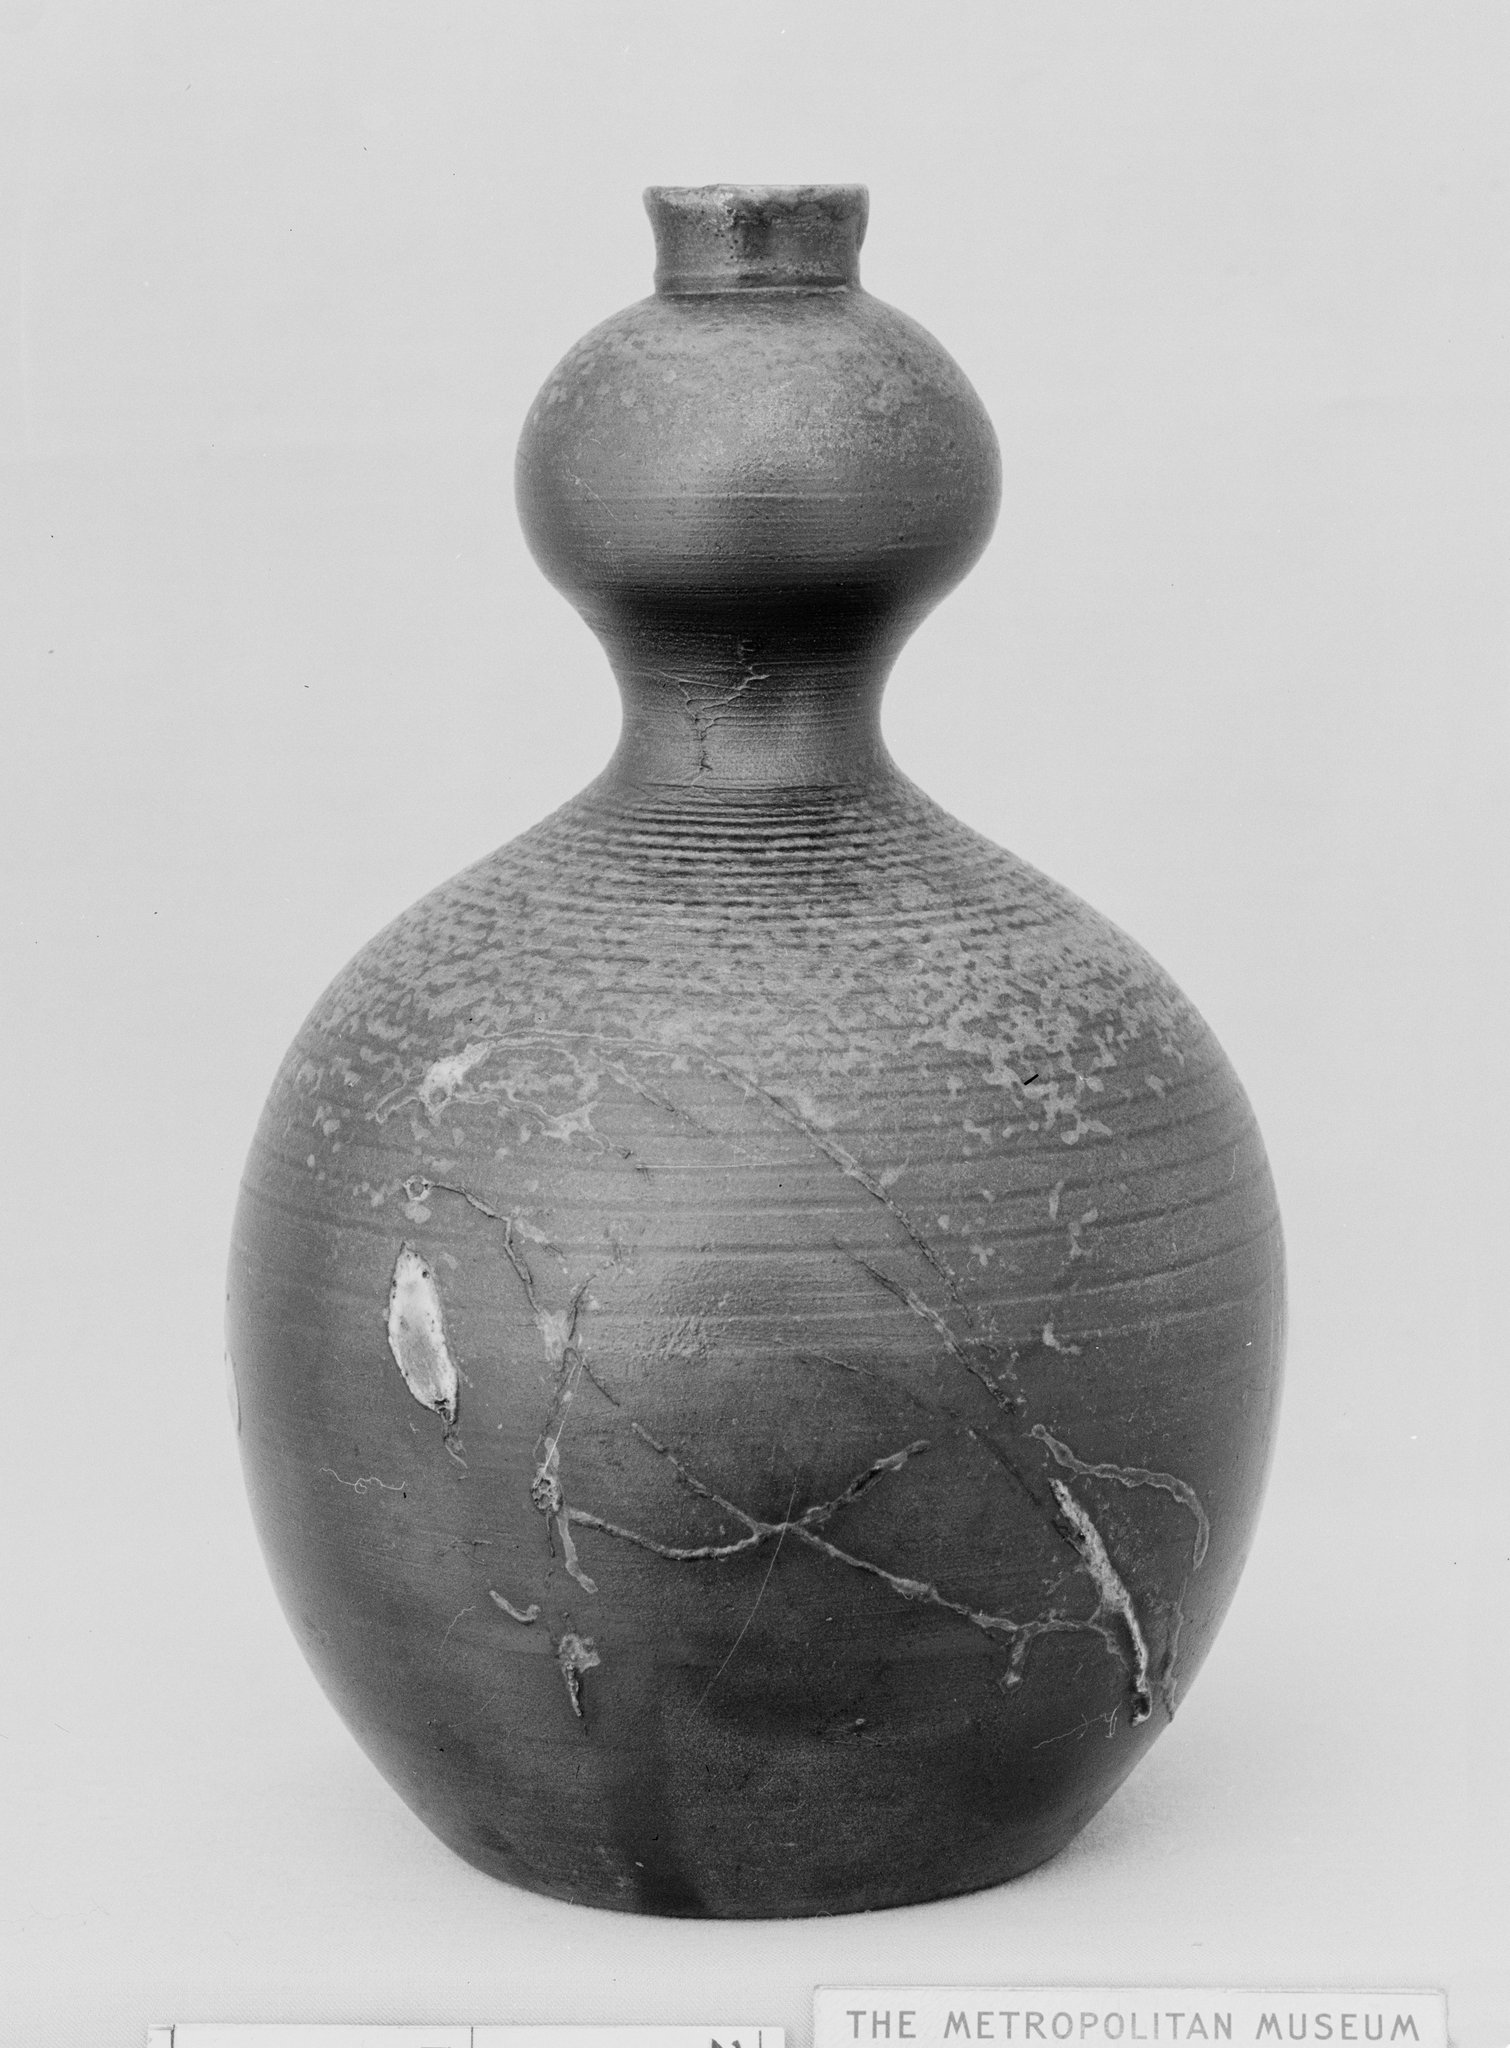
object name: bottle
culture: japanese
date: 1801-1900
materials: clay, glaze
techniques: overglaze